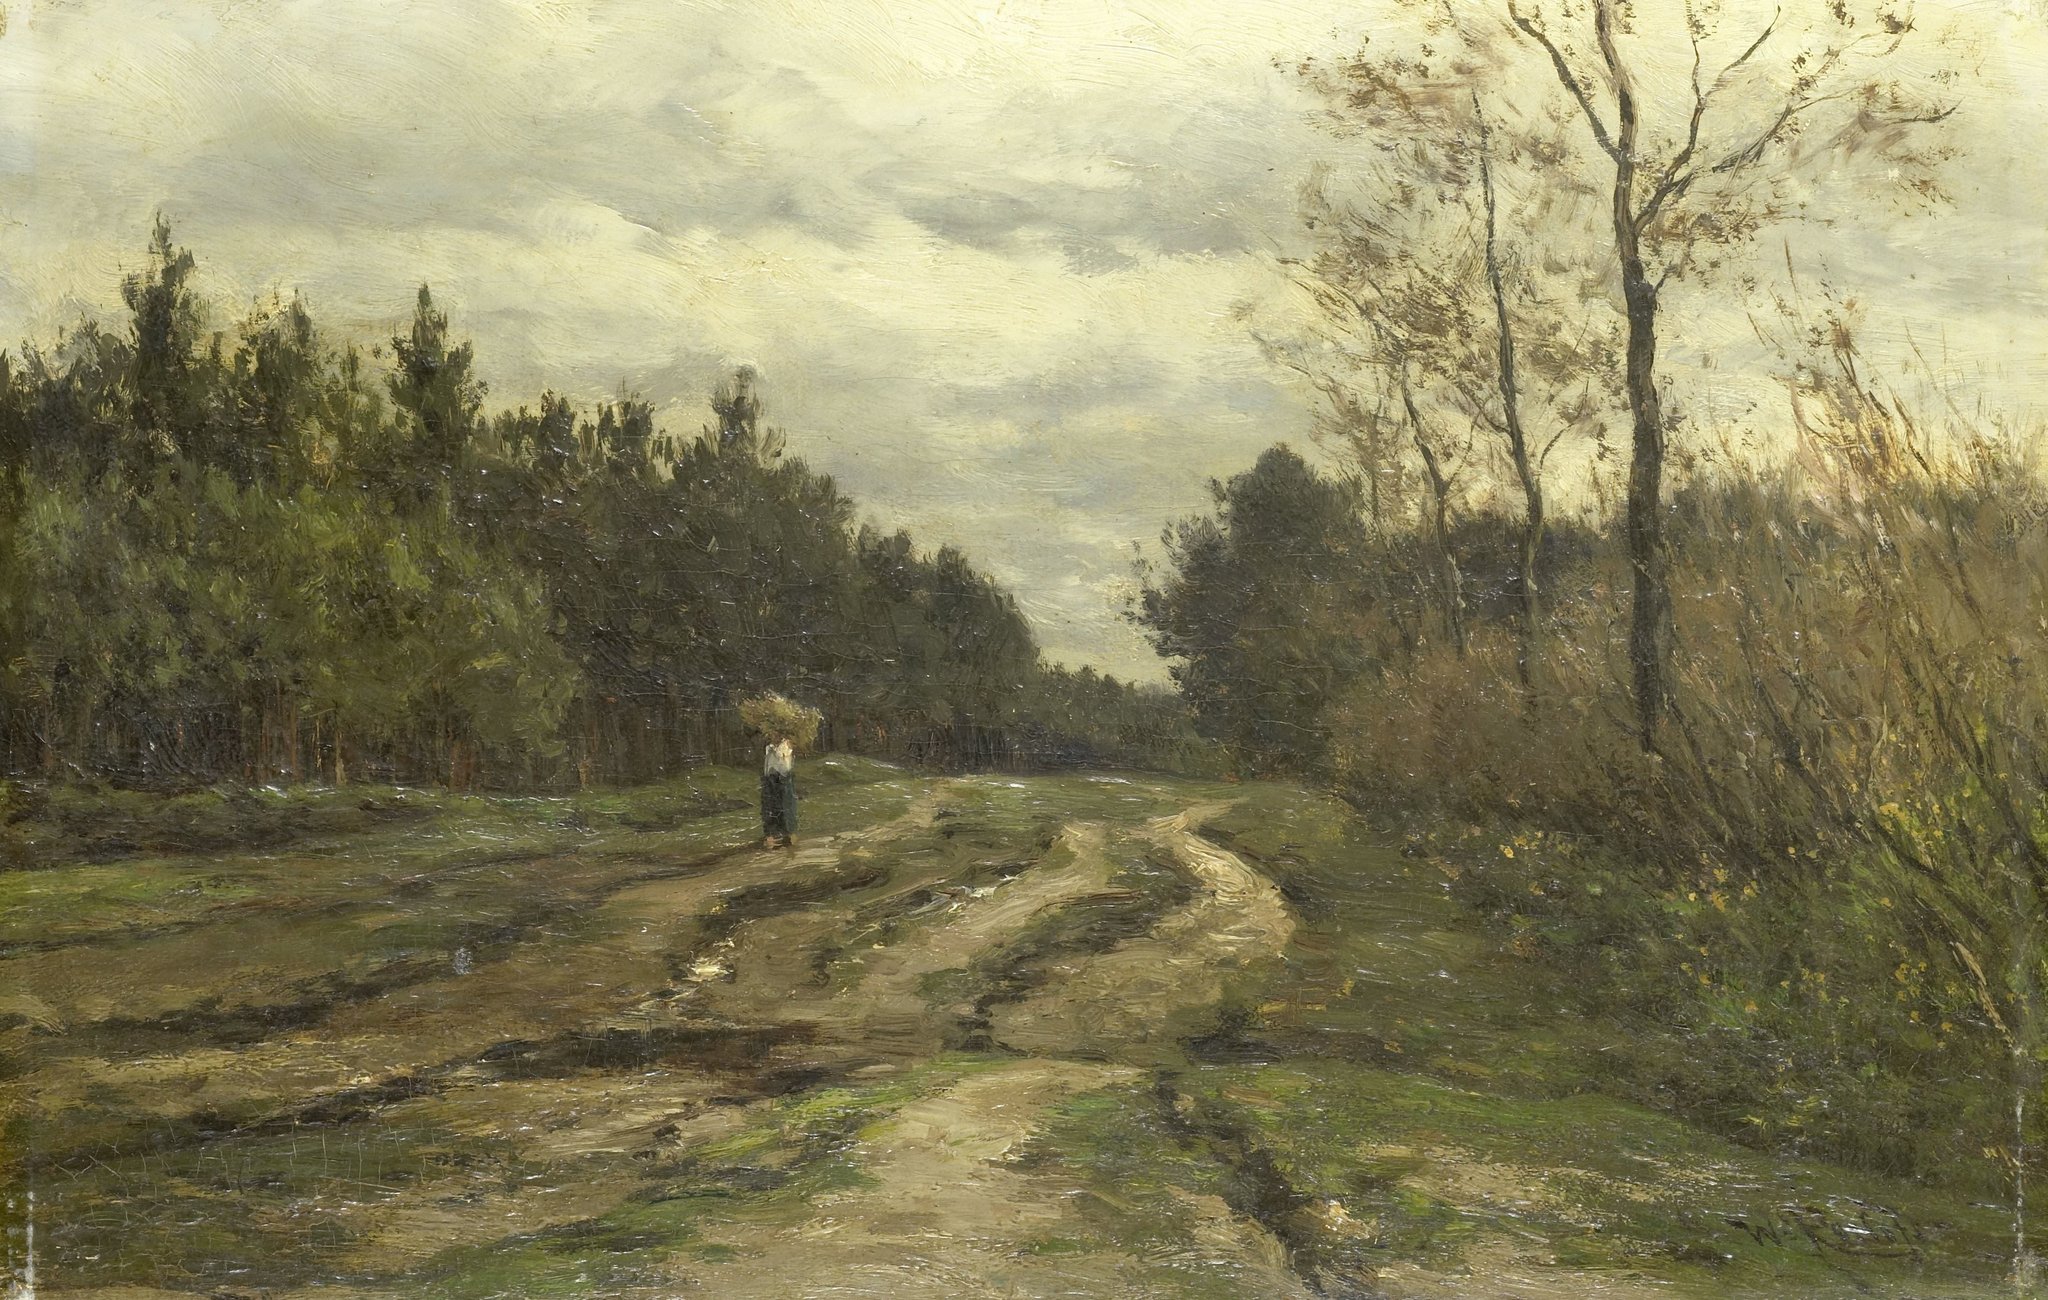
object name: painting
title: Country Road near Laren, (Province of North Holland)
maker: willem roelofs (i)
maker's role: draughtsman, painter, print maker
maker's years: 1822-1897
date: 1870-1897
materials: canvas, oil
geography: netherlands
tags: forest, wood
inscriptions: signature: ‘W. Roelofs’, label: ‘Landweg te Laren N.H.’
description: Landweg bij Laren, Noord-Holland. Een landweg met karrensporen leidt door een bos. Een vrouw loopt met een takkenbos op haar hoofd.